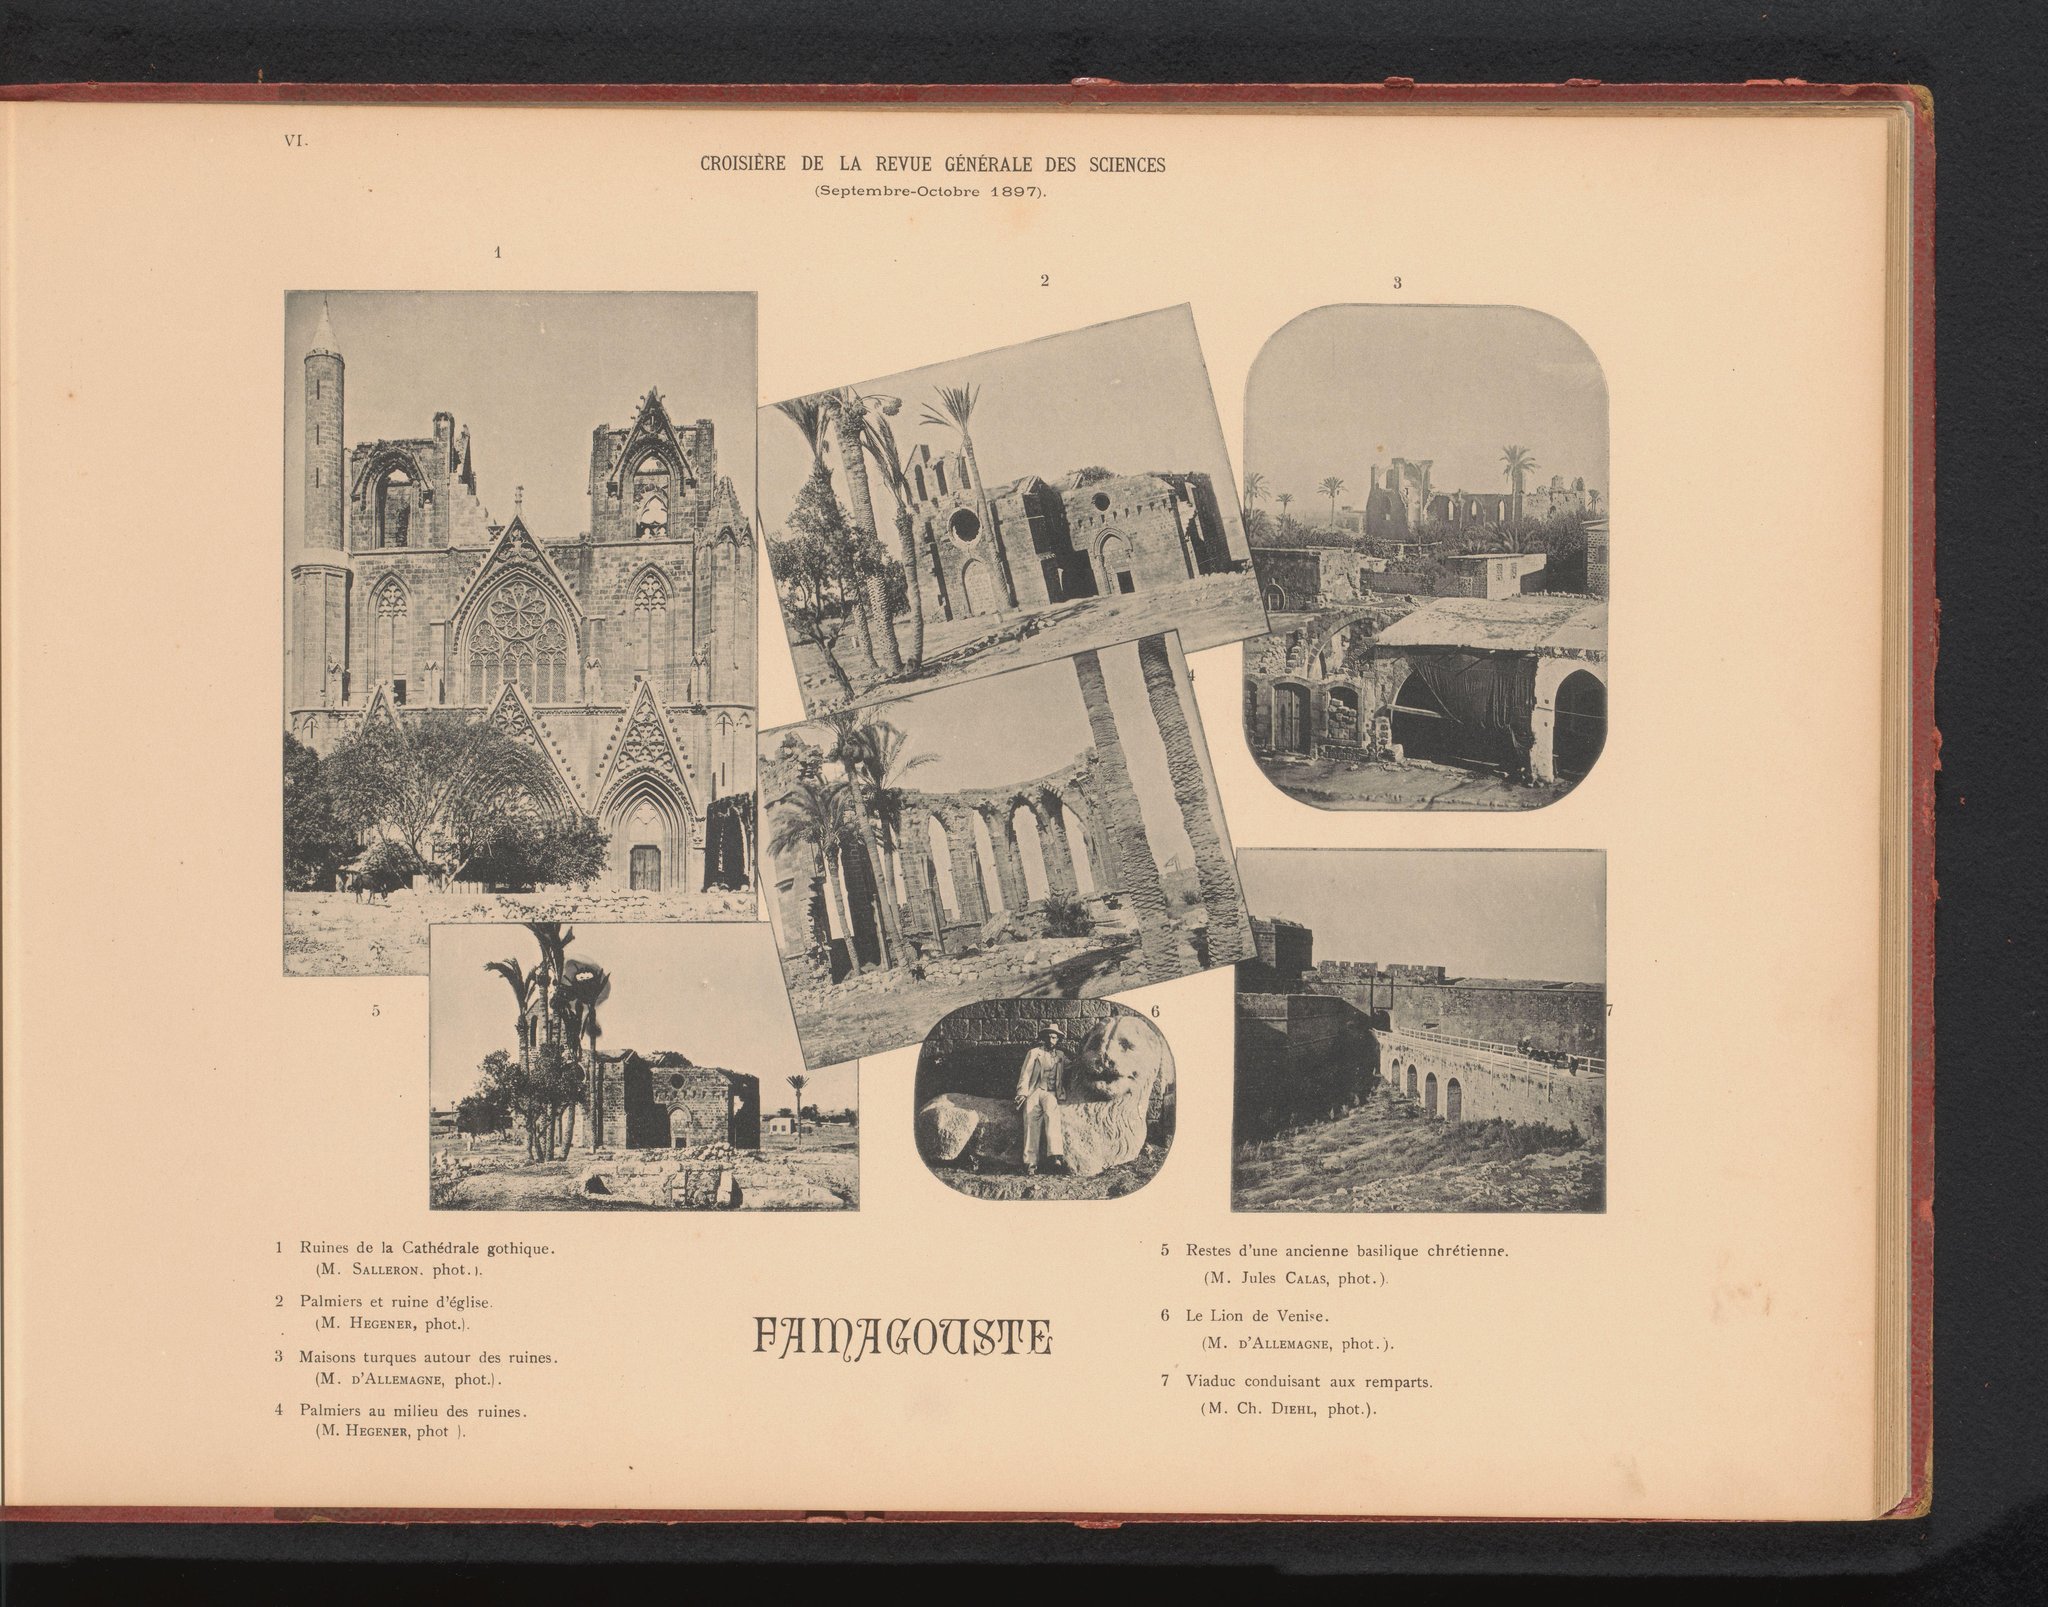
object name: page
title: Zes gezichten op Ammóchostos, Cyprus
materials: paper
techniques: photograph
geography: ammóchostos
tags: prospect of village, silhouette of village, ruin of a building ~ architecture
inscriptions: inscription: ‘1 Porte du Lion./ (M. d'Allemagne, phot.)./ 2 Ruines d'une ancienne église gothique./ (M. d'Allemagne, phot.)./ 3 Arrivée des touristes à Famagouste./ (M. l'Abbé Stoffaes, phot.)./ 4 Paysage de Famagouste. Au premier plan, femmes musul-/ manes. (M. Ernest Diehl, phot.)./ 5 Portail près du parvis de la cathédrale./ (M. Charles Diehl, phot.)./ 6 Ruines d'une basilique chrétienne./ (M. Ch Diehl, phot.).’, number: ‘V.’